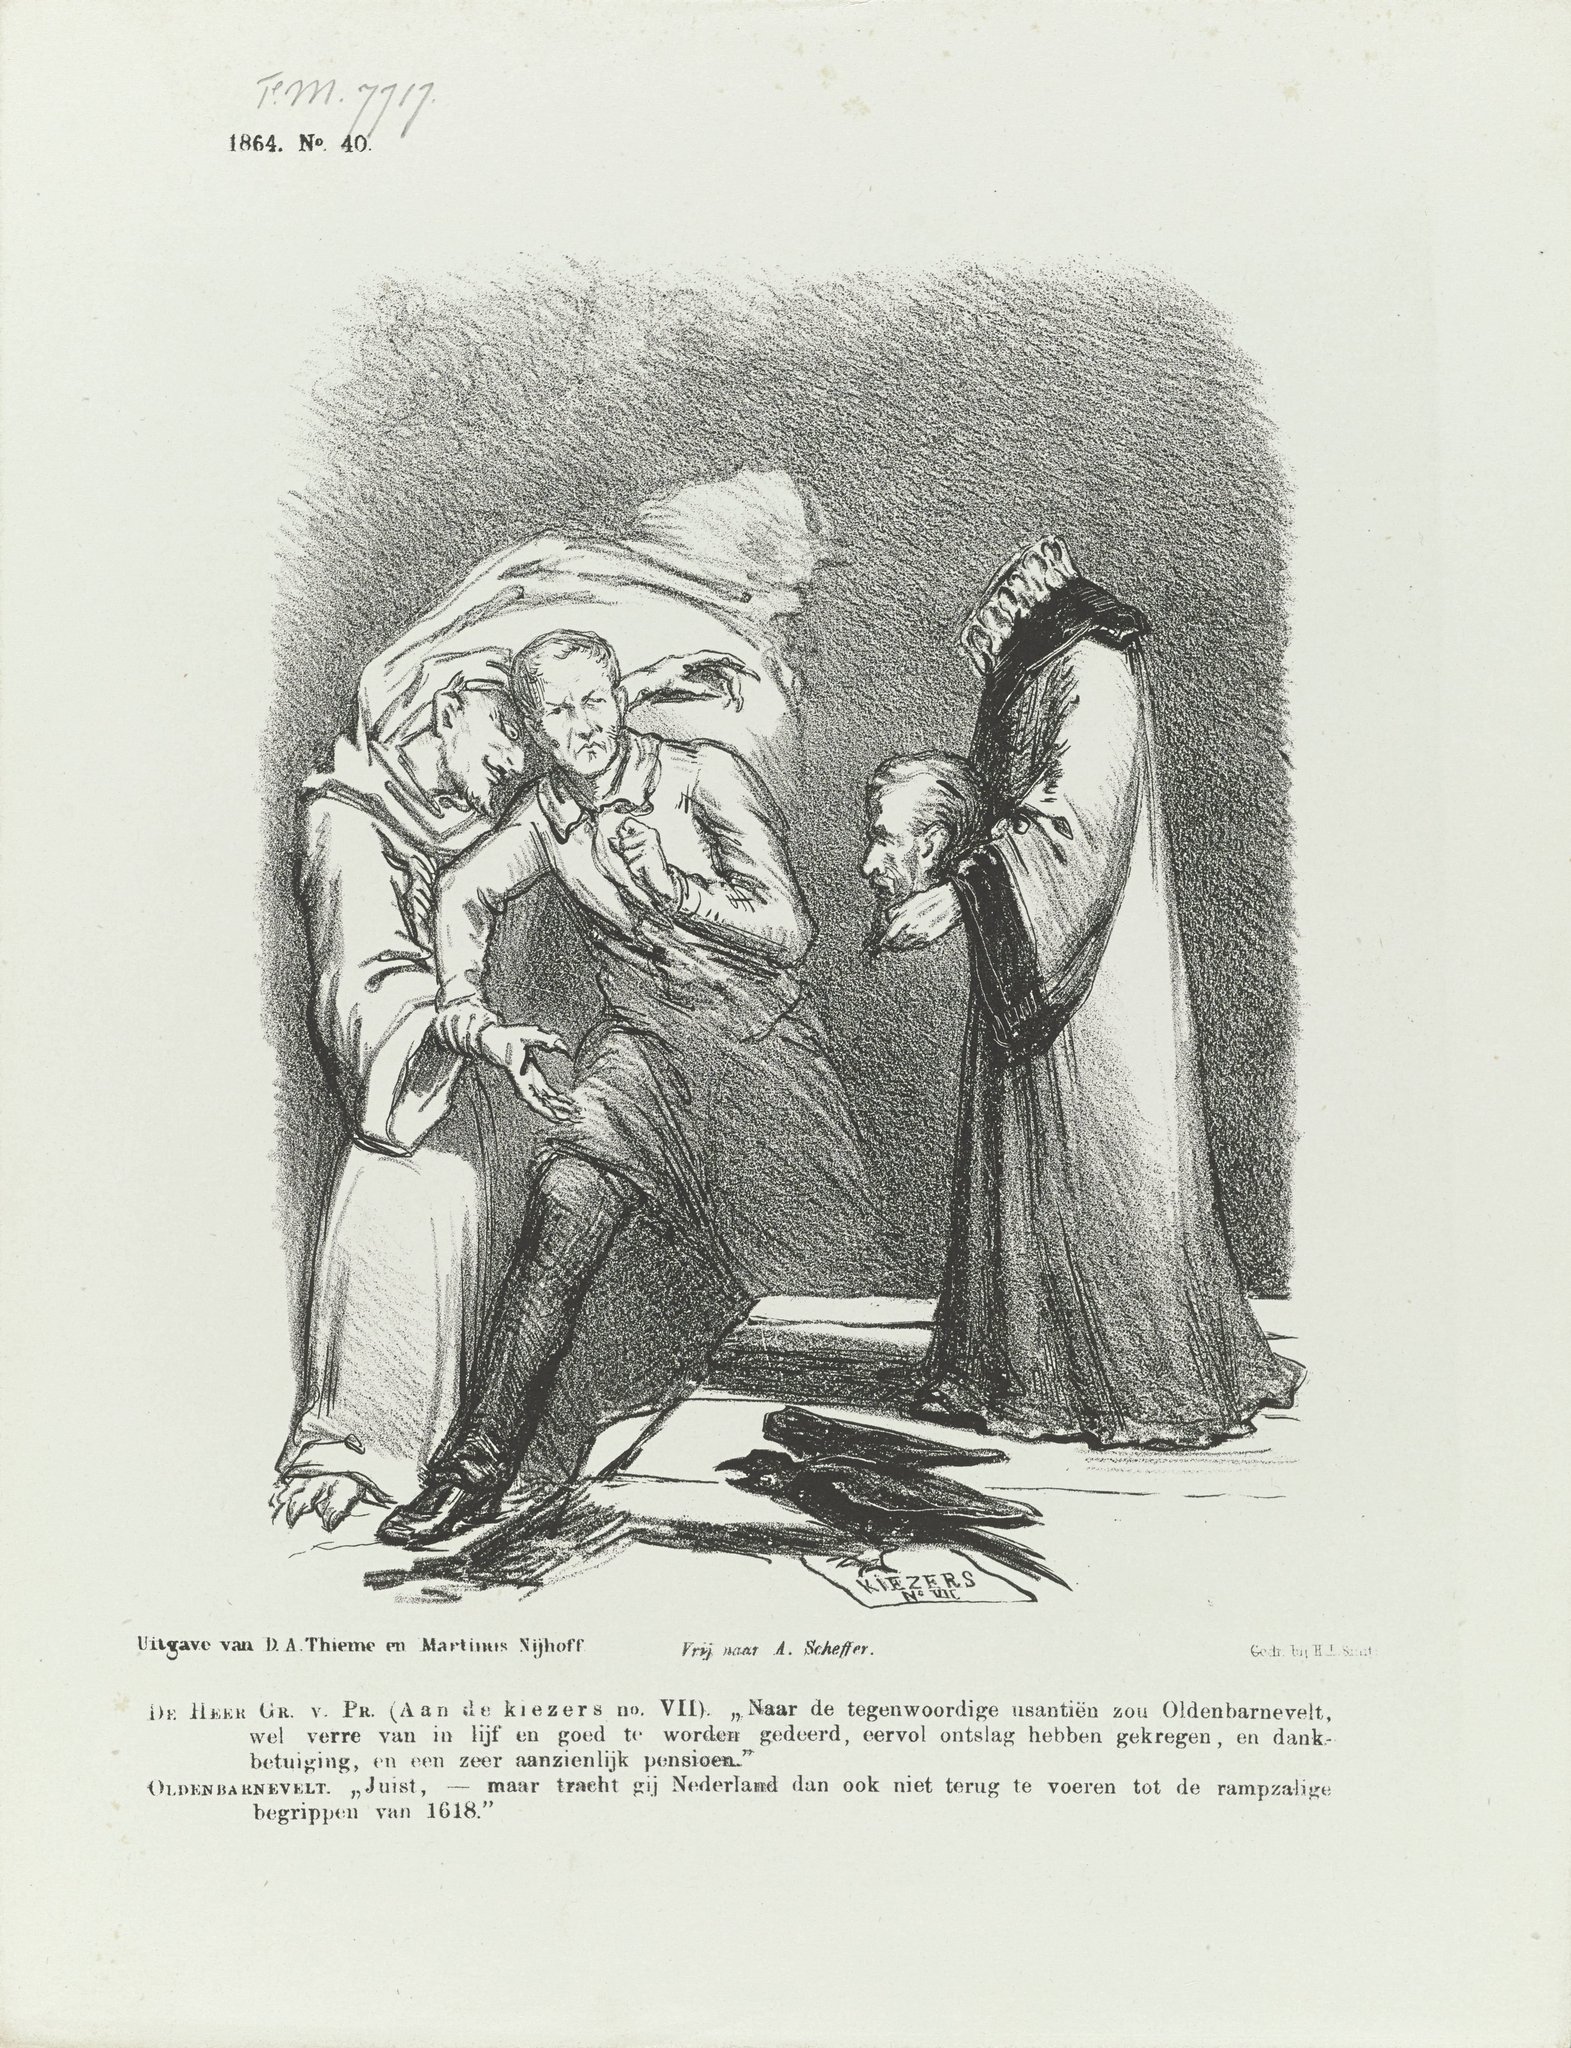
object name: cartoon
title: Spotprent op Groen van Prinsterer en de geest van Van Oldenbarnevelt, 1864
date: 1864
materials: paper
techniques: lithograph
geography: netherlands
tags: johan van oldenbarnevelt, guillaume groen van prinsterer, faust, mephistopheles, name of the demonic tempter in the literary versions of the faust legends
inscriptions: collector's mark: Lugt 2228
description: Spotprent op Groen van Prinsterer als Faust voor wie de geest van Van Oldenbarnevelt als cefalofoor verschijnt. Naar het schilderij van Ary Scheffer. Plaat verschenen bij het weekblad De Nederlandsche Spectator, nr. 40, 1 oktober 1864.